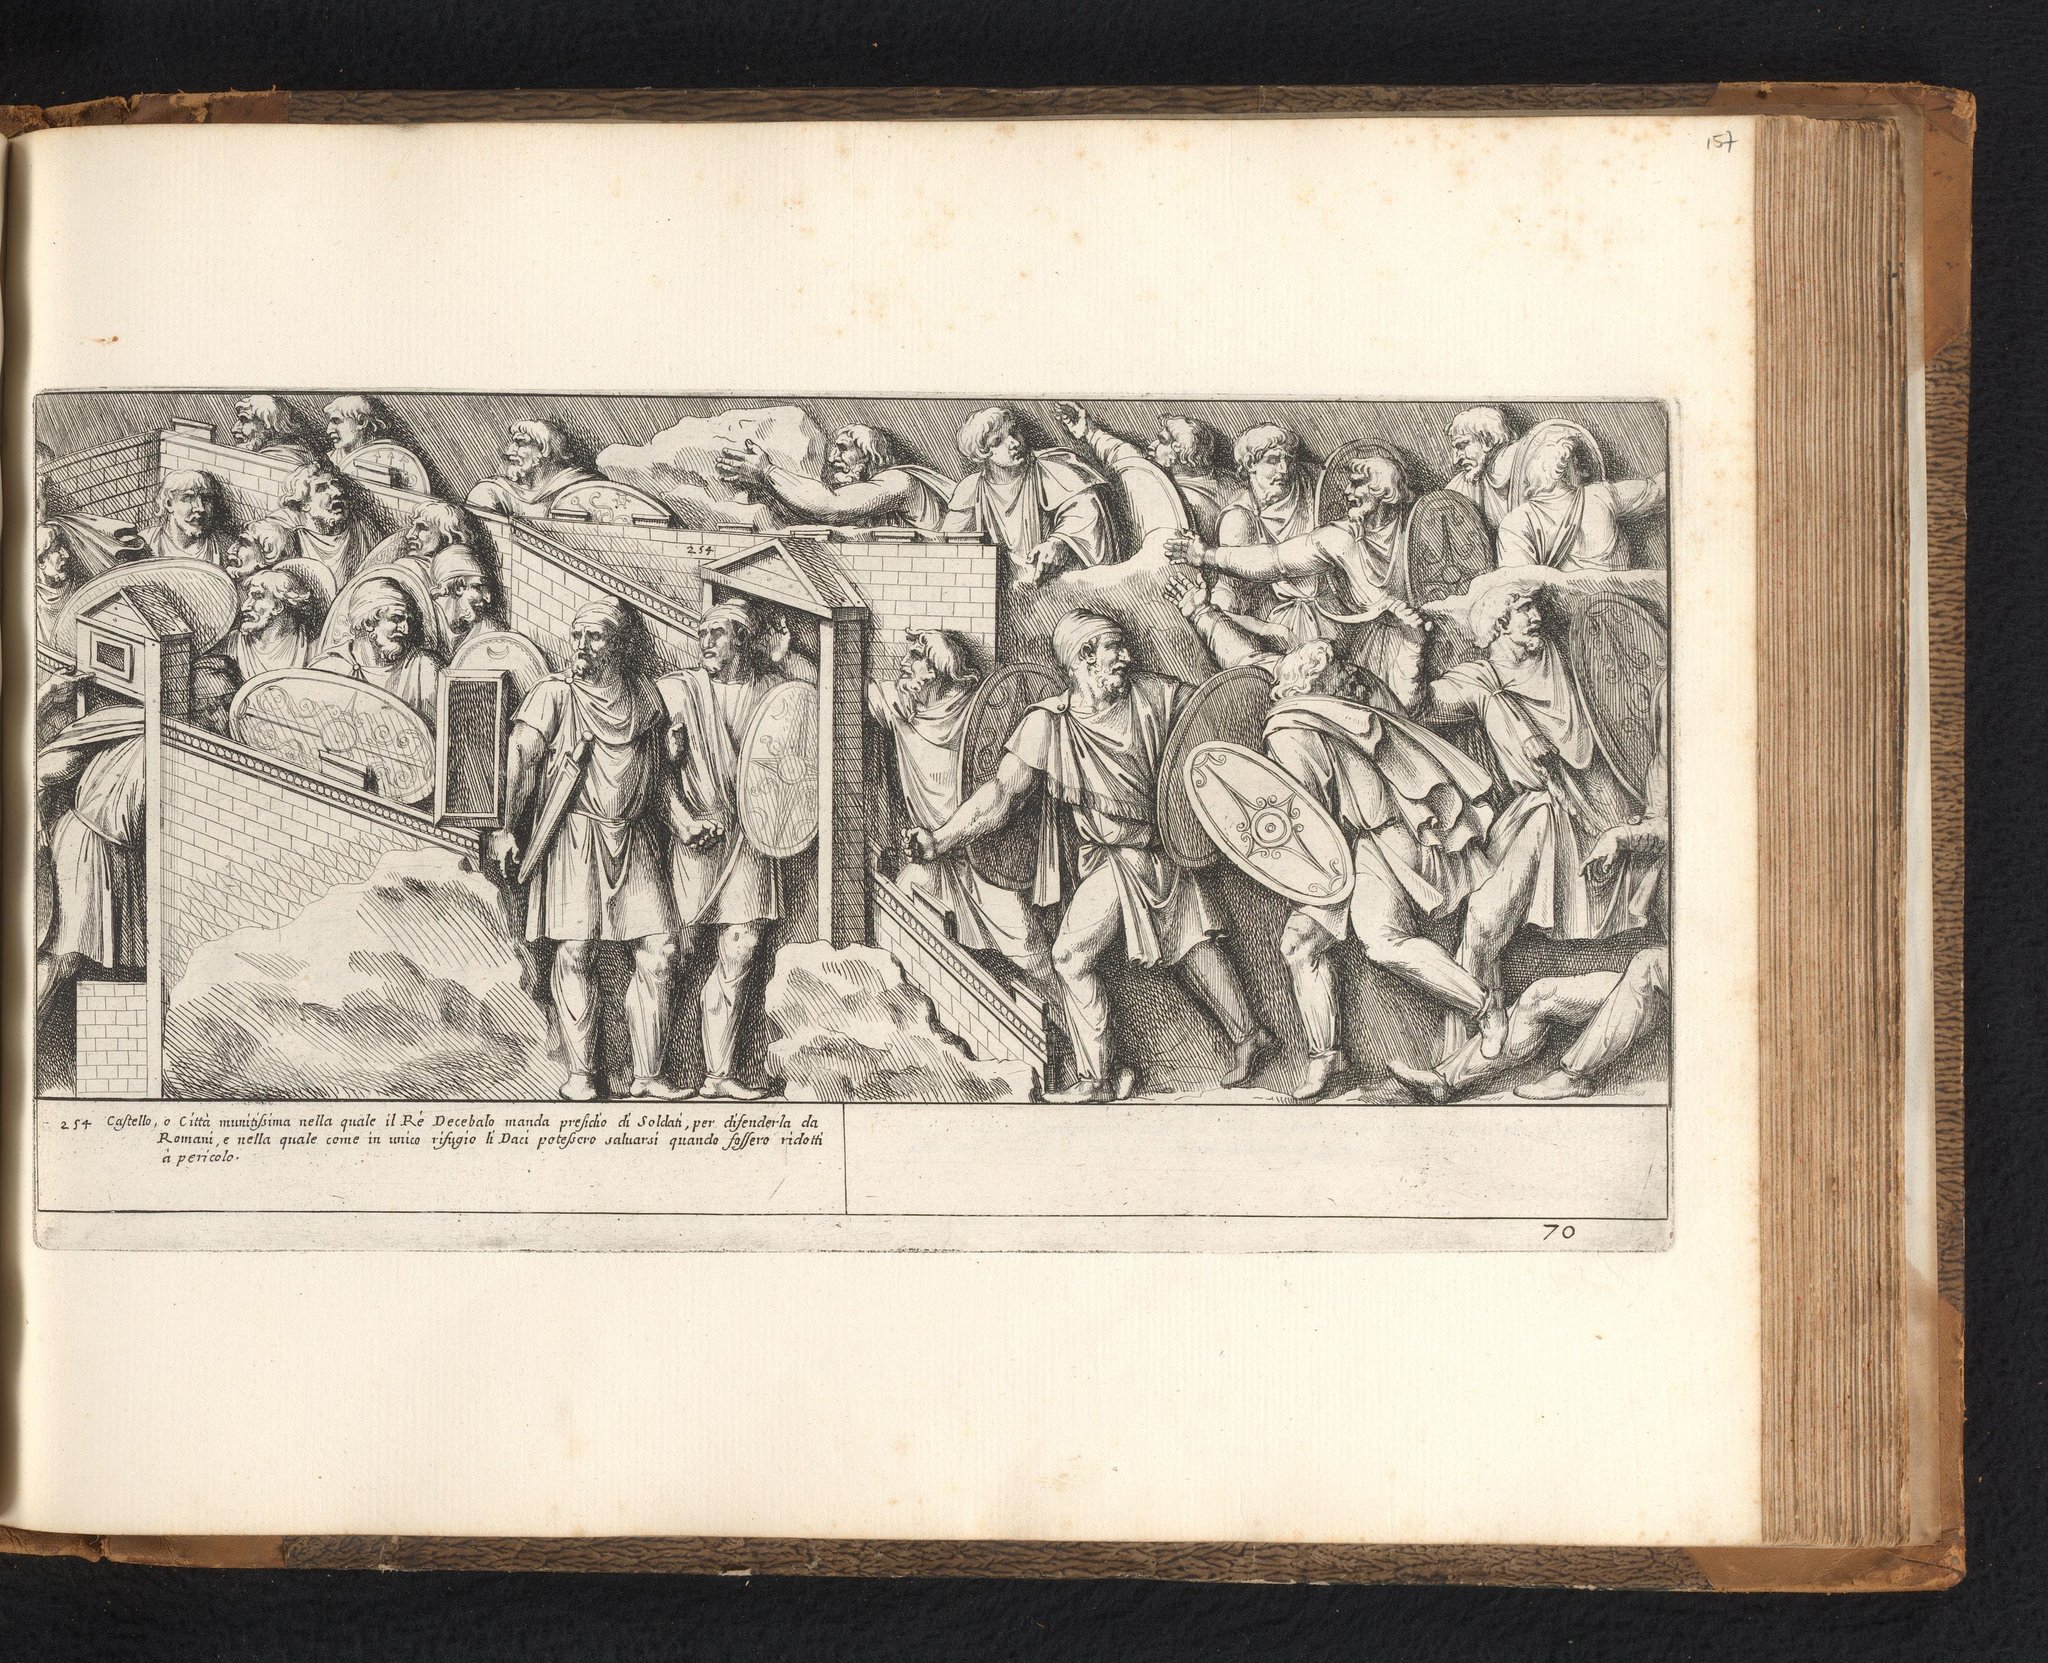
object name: print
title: Colonna Traiana eretta dal senato, e popolo Romano all' imperatore Traiano Augusto nel suo foro in Rom (...)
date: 1637-1691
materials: paper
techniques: etching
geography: rome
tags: triumphal column with helical friezes, piece of sculpture, reproduction of a piece of sculpture, the soldier; the soldier's life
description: Detail van het spiraalvormige gebeeldhouwde fries op de Zuil van Trajanus. Het fries toont de oorlogen tussen de Romeinen en de Daciërs. Verklarende nummers in de ondermarge. Prent maakt deel uit van een album.